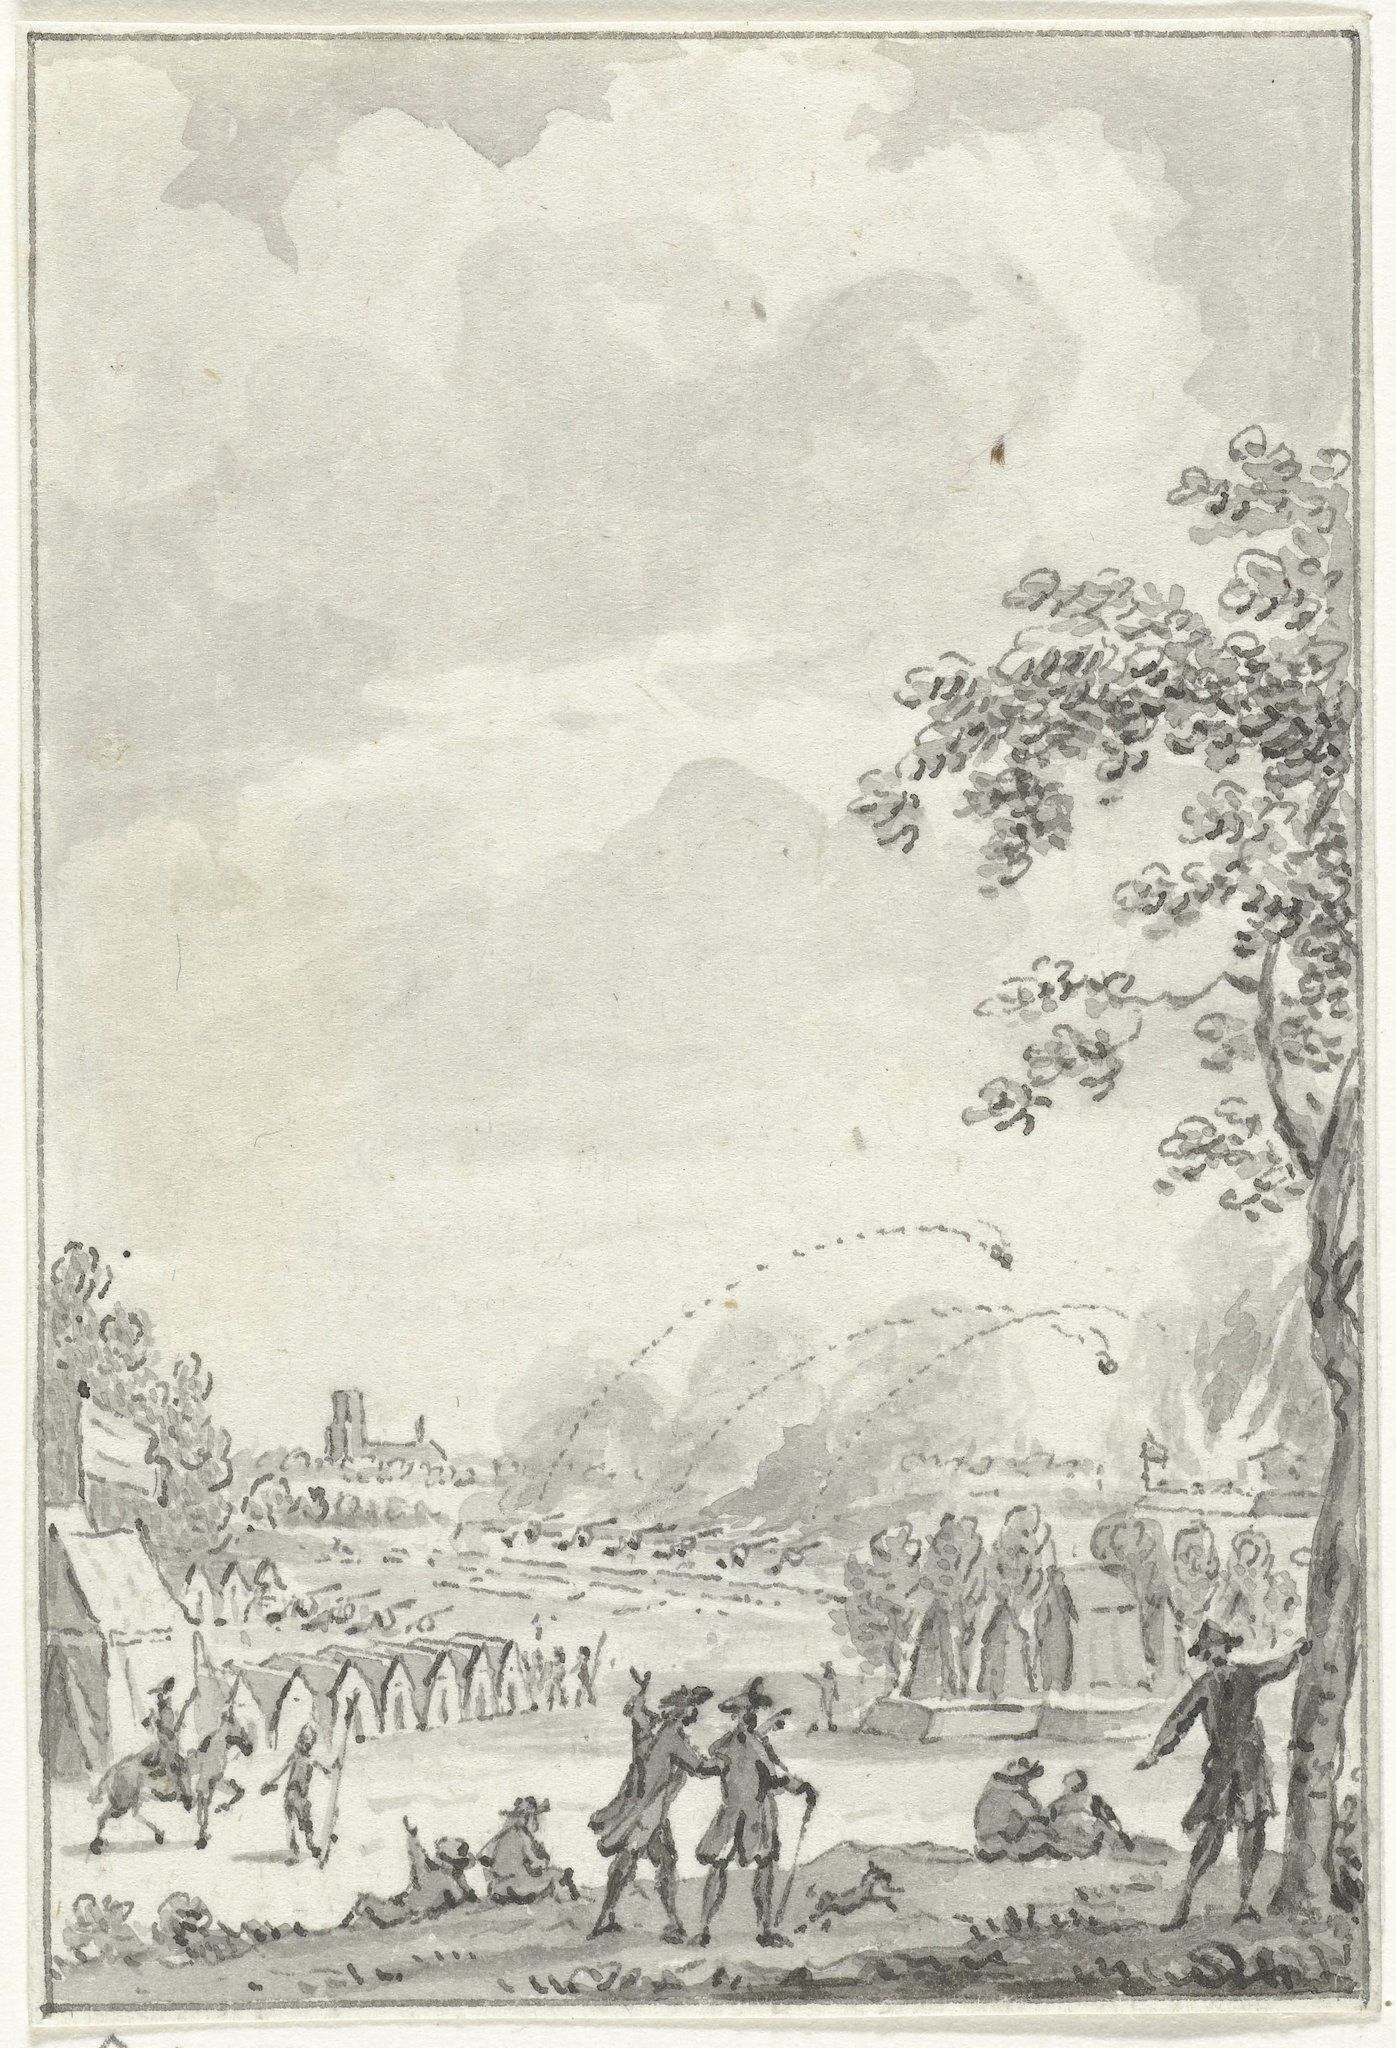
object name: drawing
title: Artilleriekamp bij Breda, juni 1769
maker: jacobus buys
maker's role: draughtsman, print maker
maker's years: 1724-1801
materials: ink, paper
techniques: brush, pen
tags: land forces (+ artillery), military training, historical events and situations